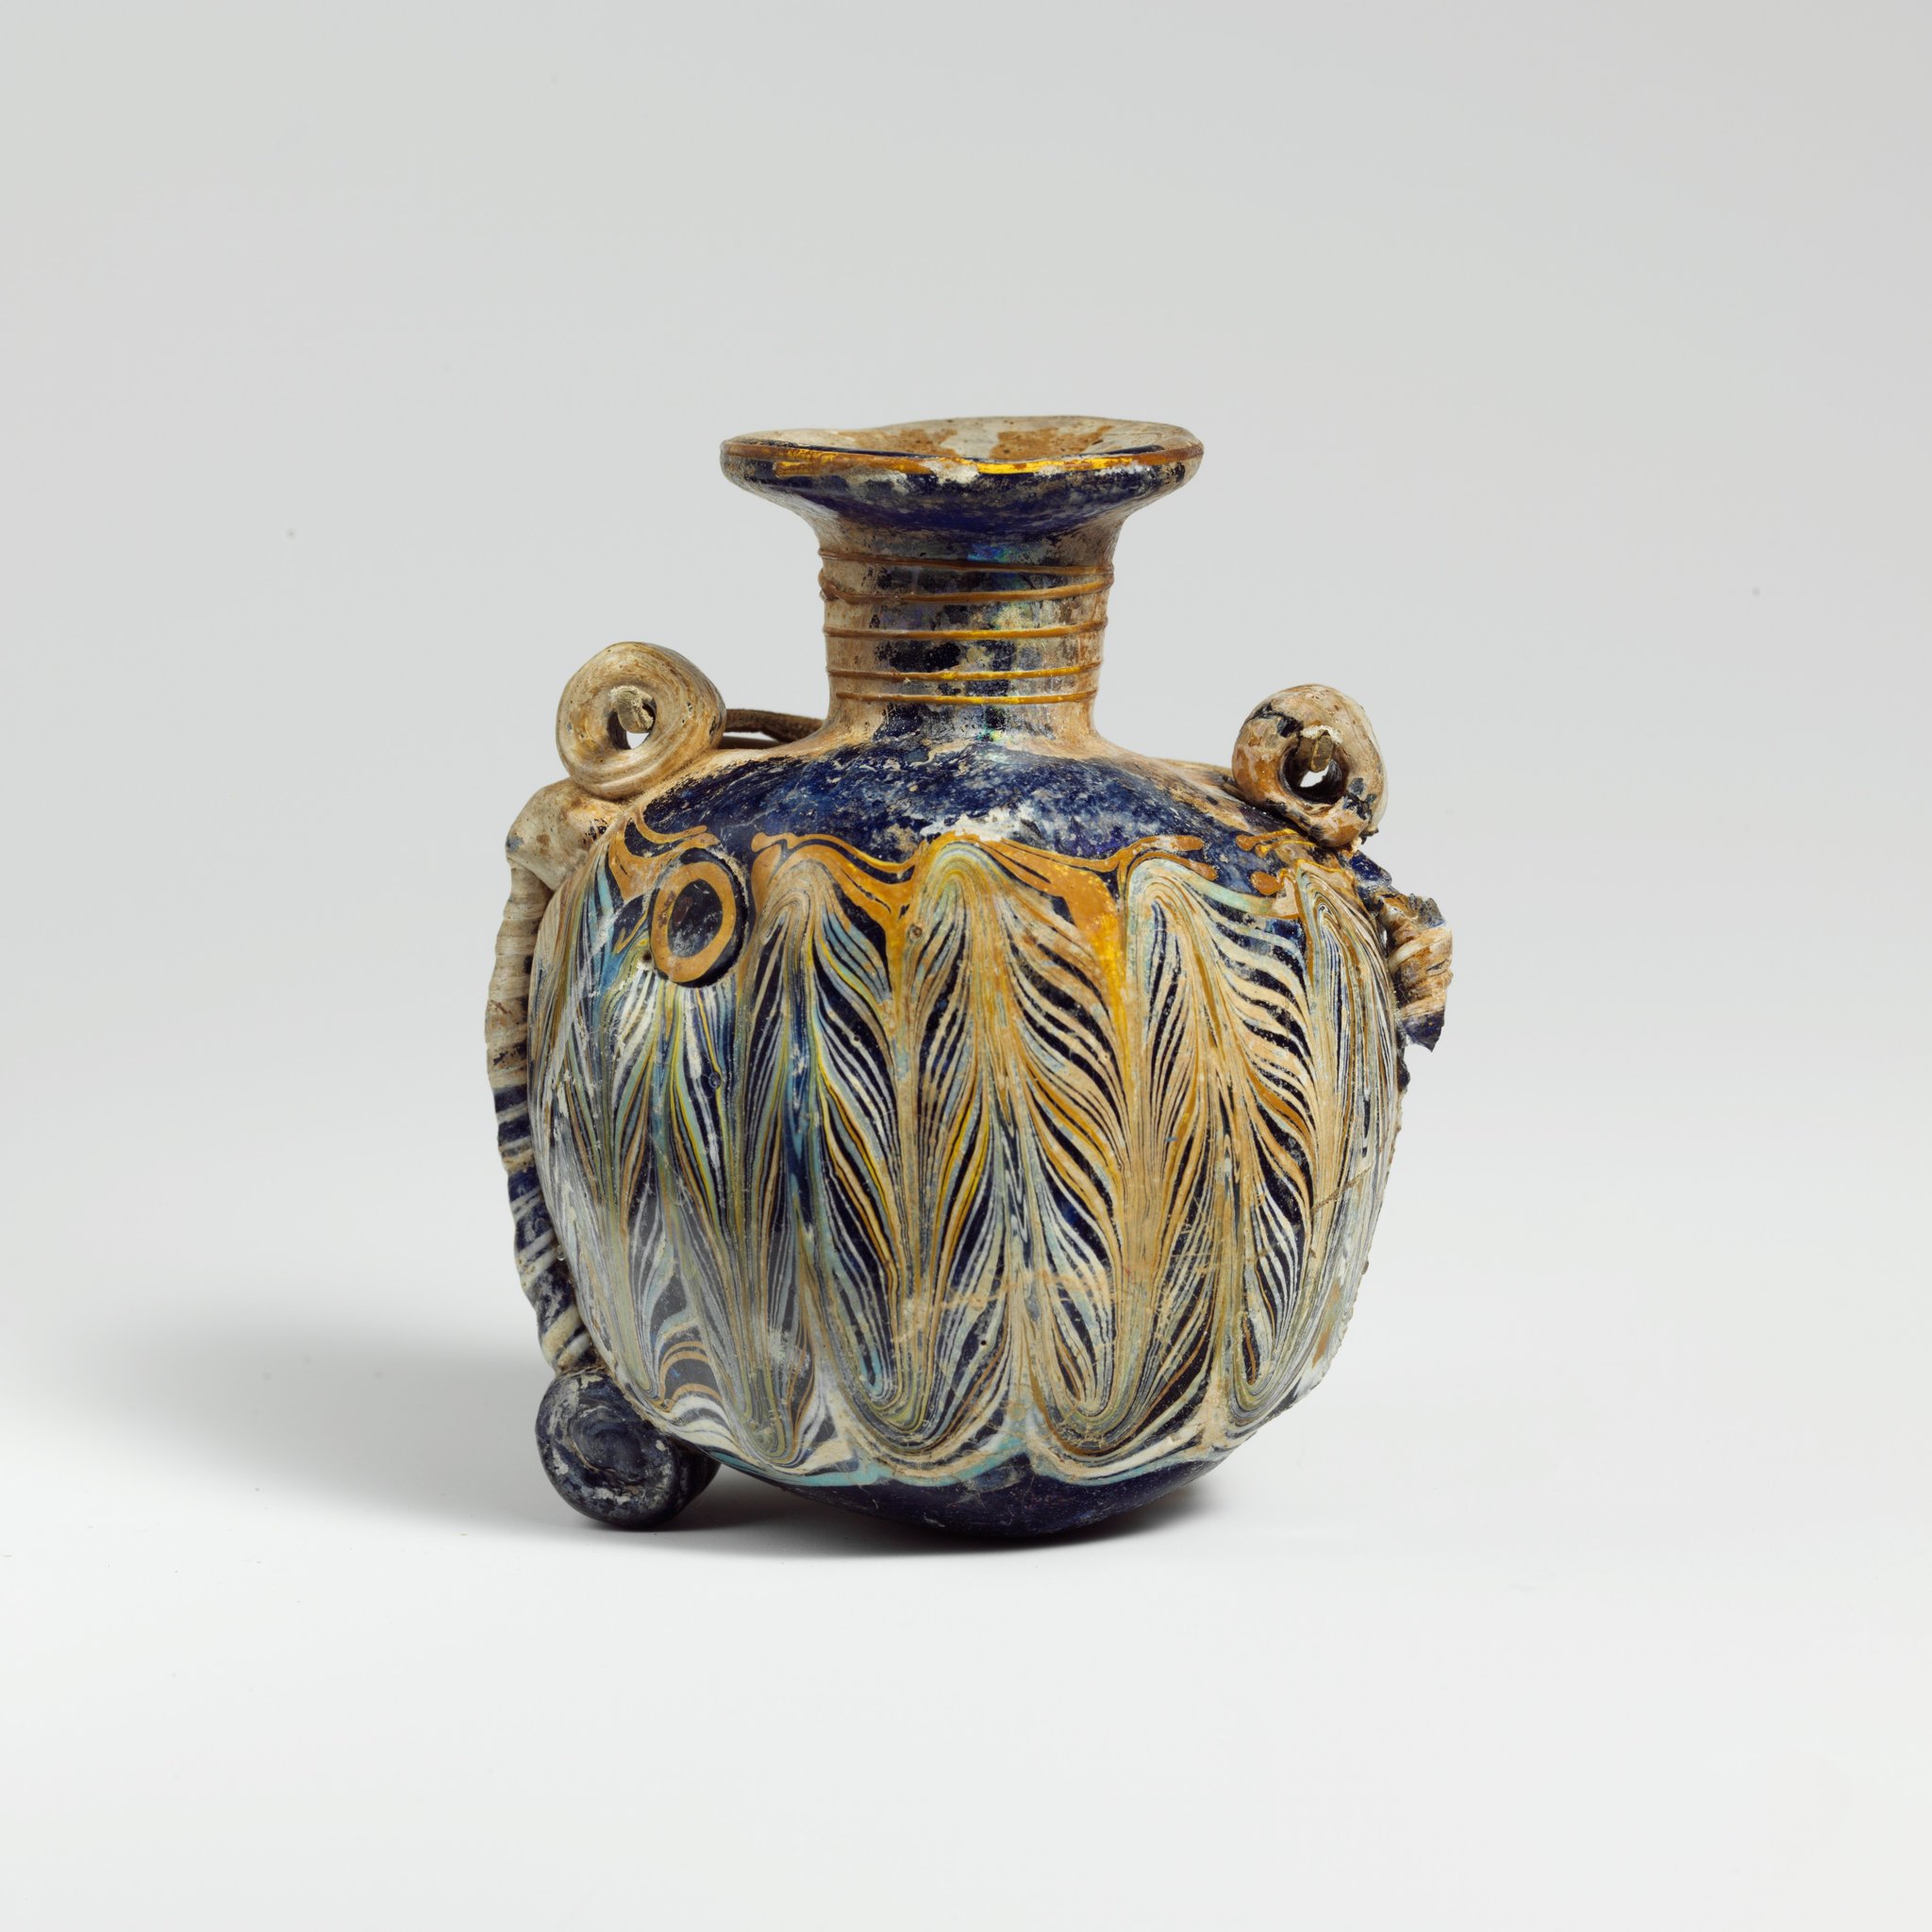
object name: aryballos, lentoid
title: Glass lentoid aryballos (perfume bottle)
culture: eastern mediterranean or italian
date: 334-268 BCE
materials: glass